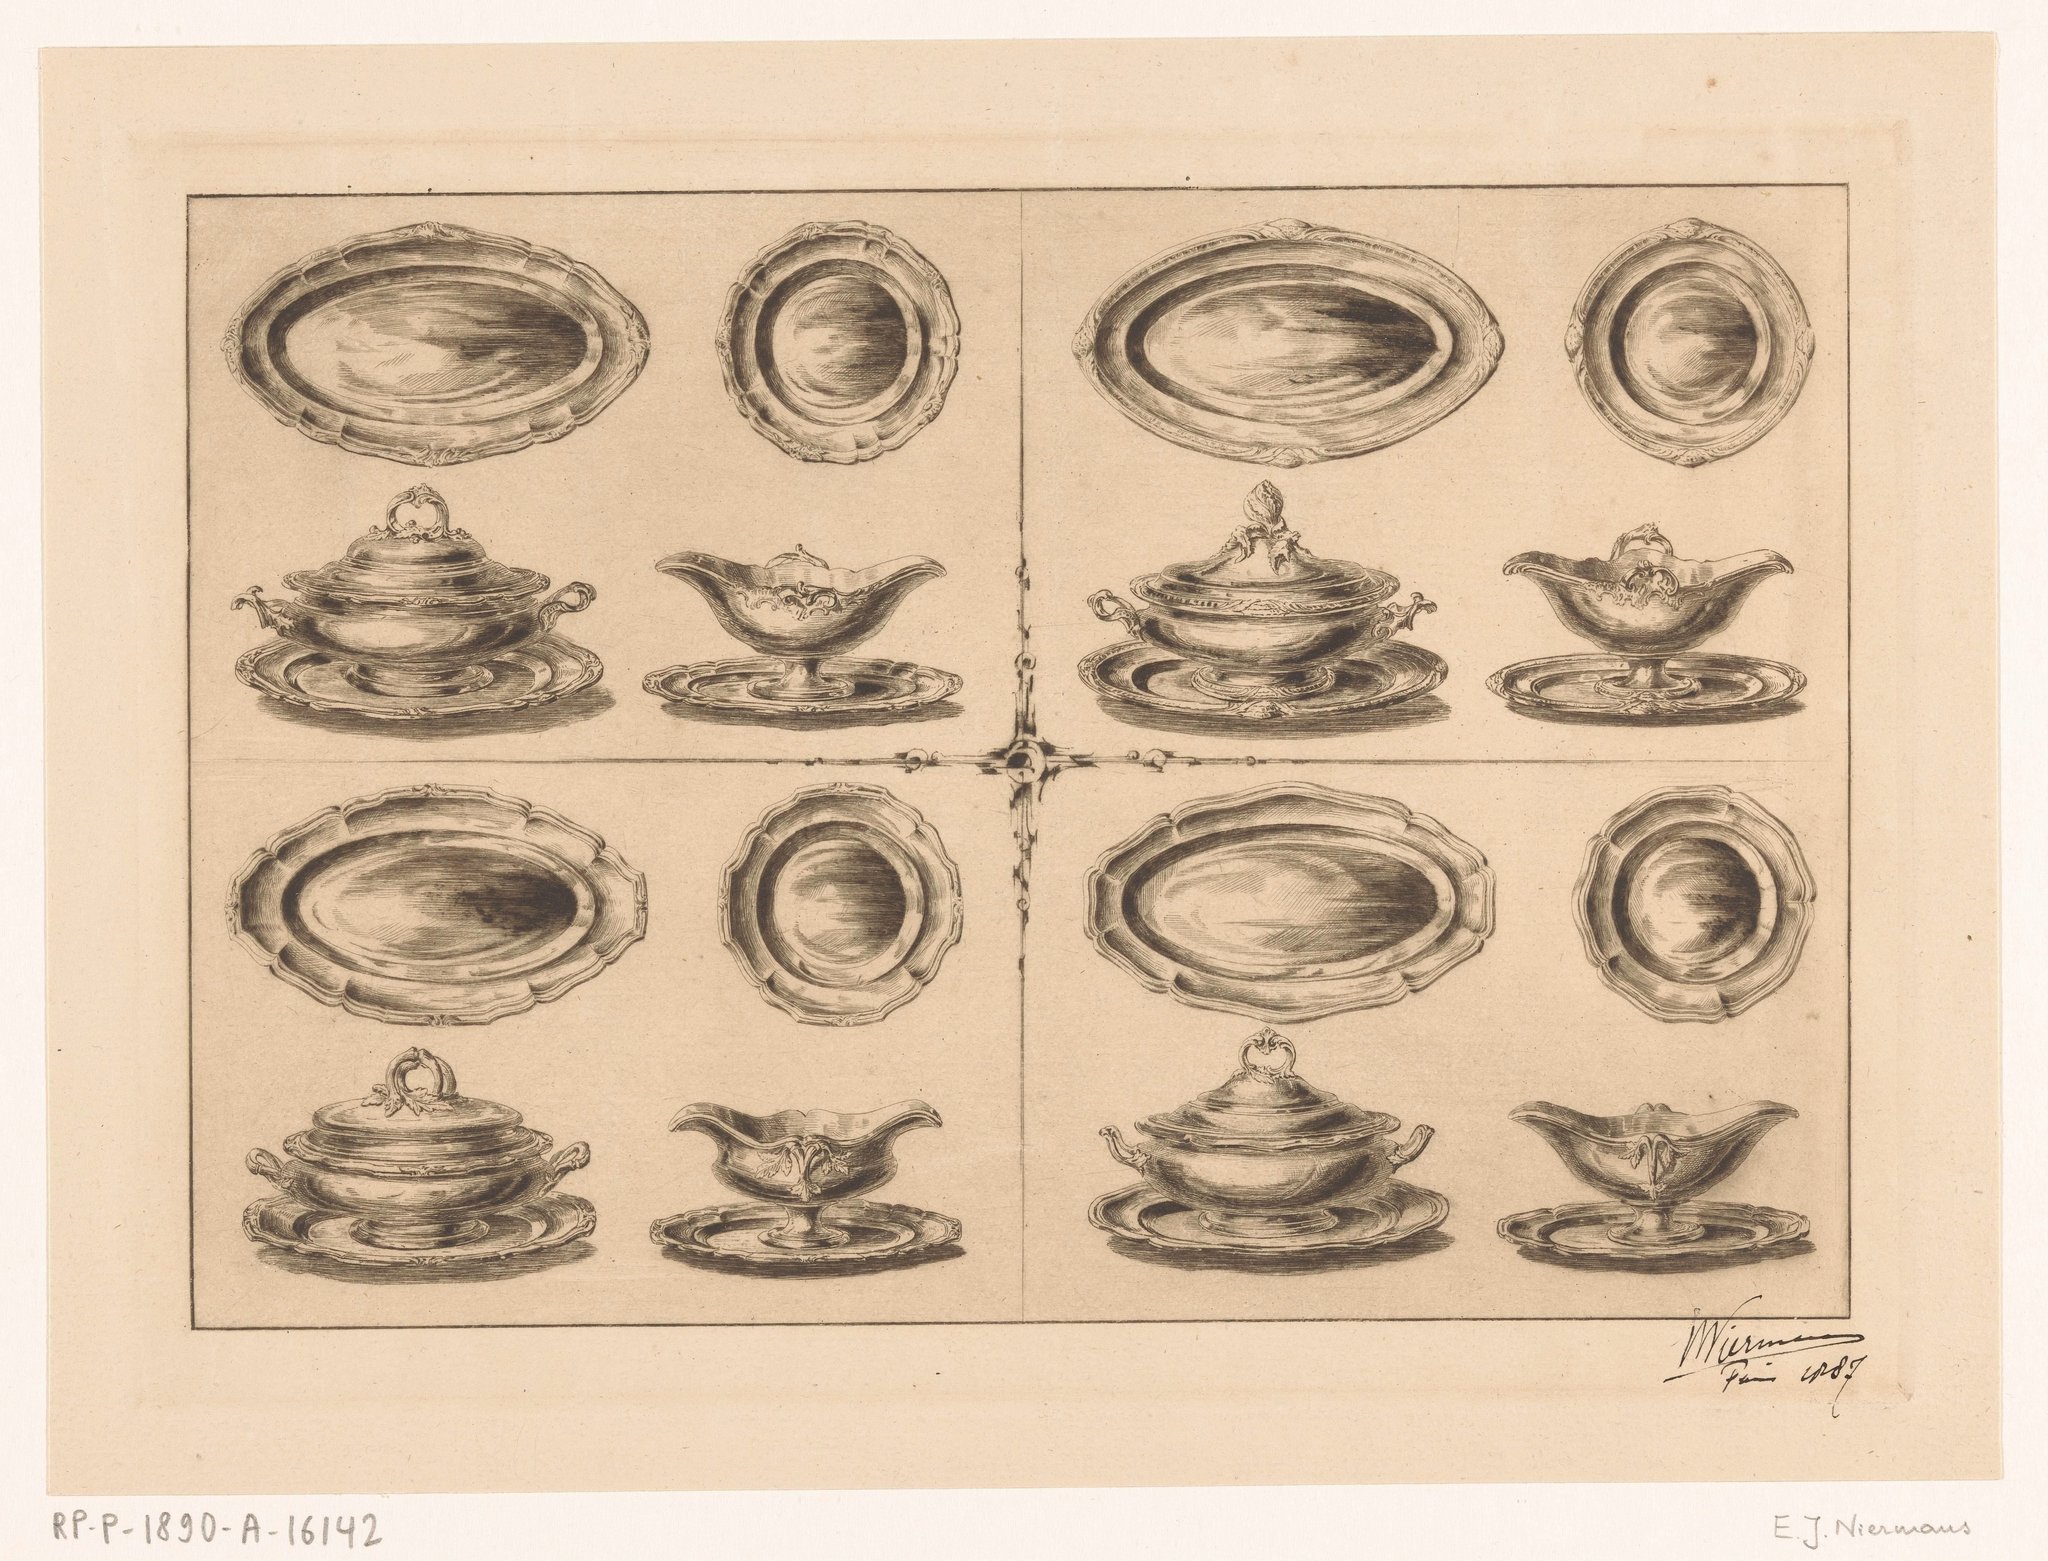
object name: print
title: Vier dienbladen, borden, dekschalen en sauskommen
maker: eduard niermans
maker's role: print maker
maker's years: 1859-1928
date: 1887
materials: paper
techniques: etching, intaglio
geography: paris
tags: dinner-service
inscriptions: collector's mark: Lugt 2228